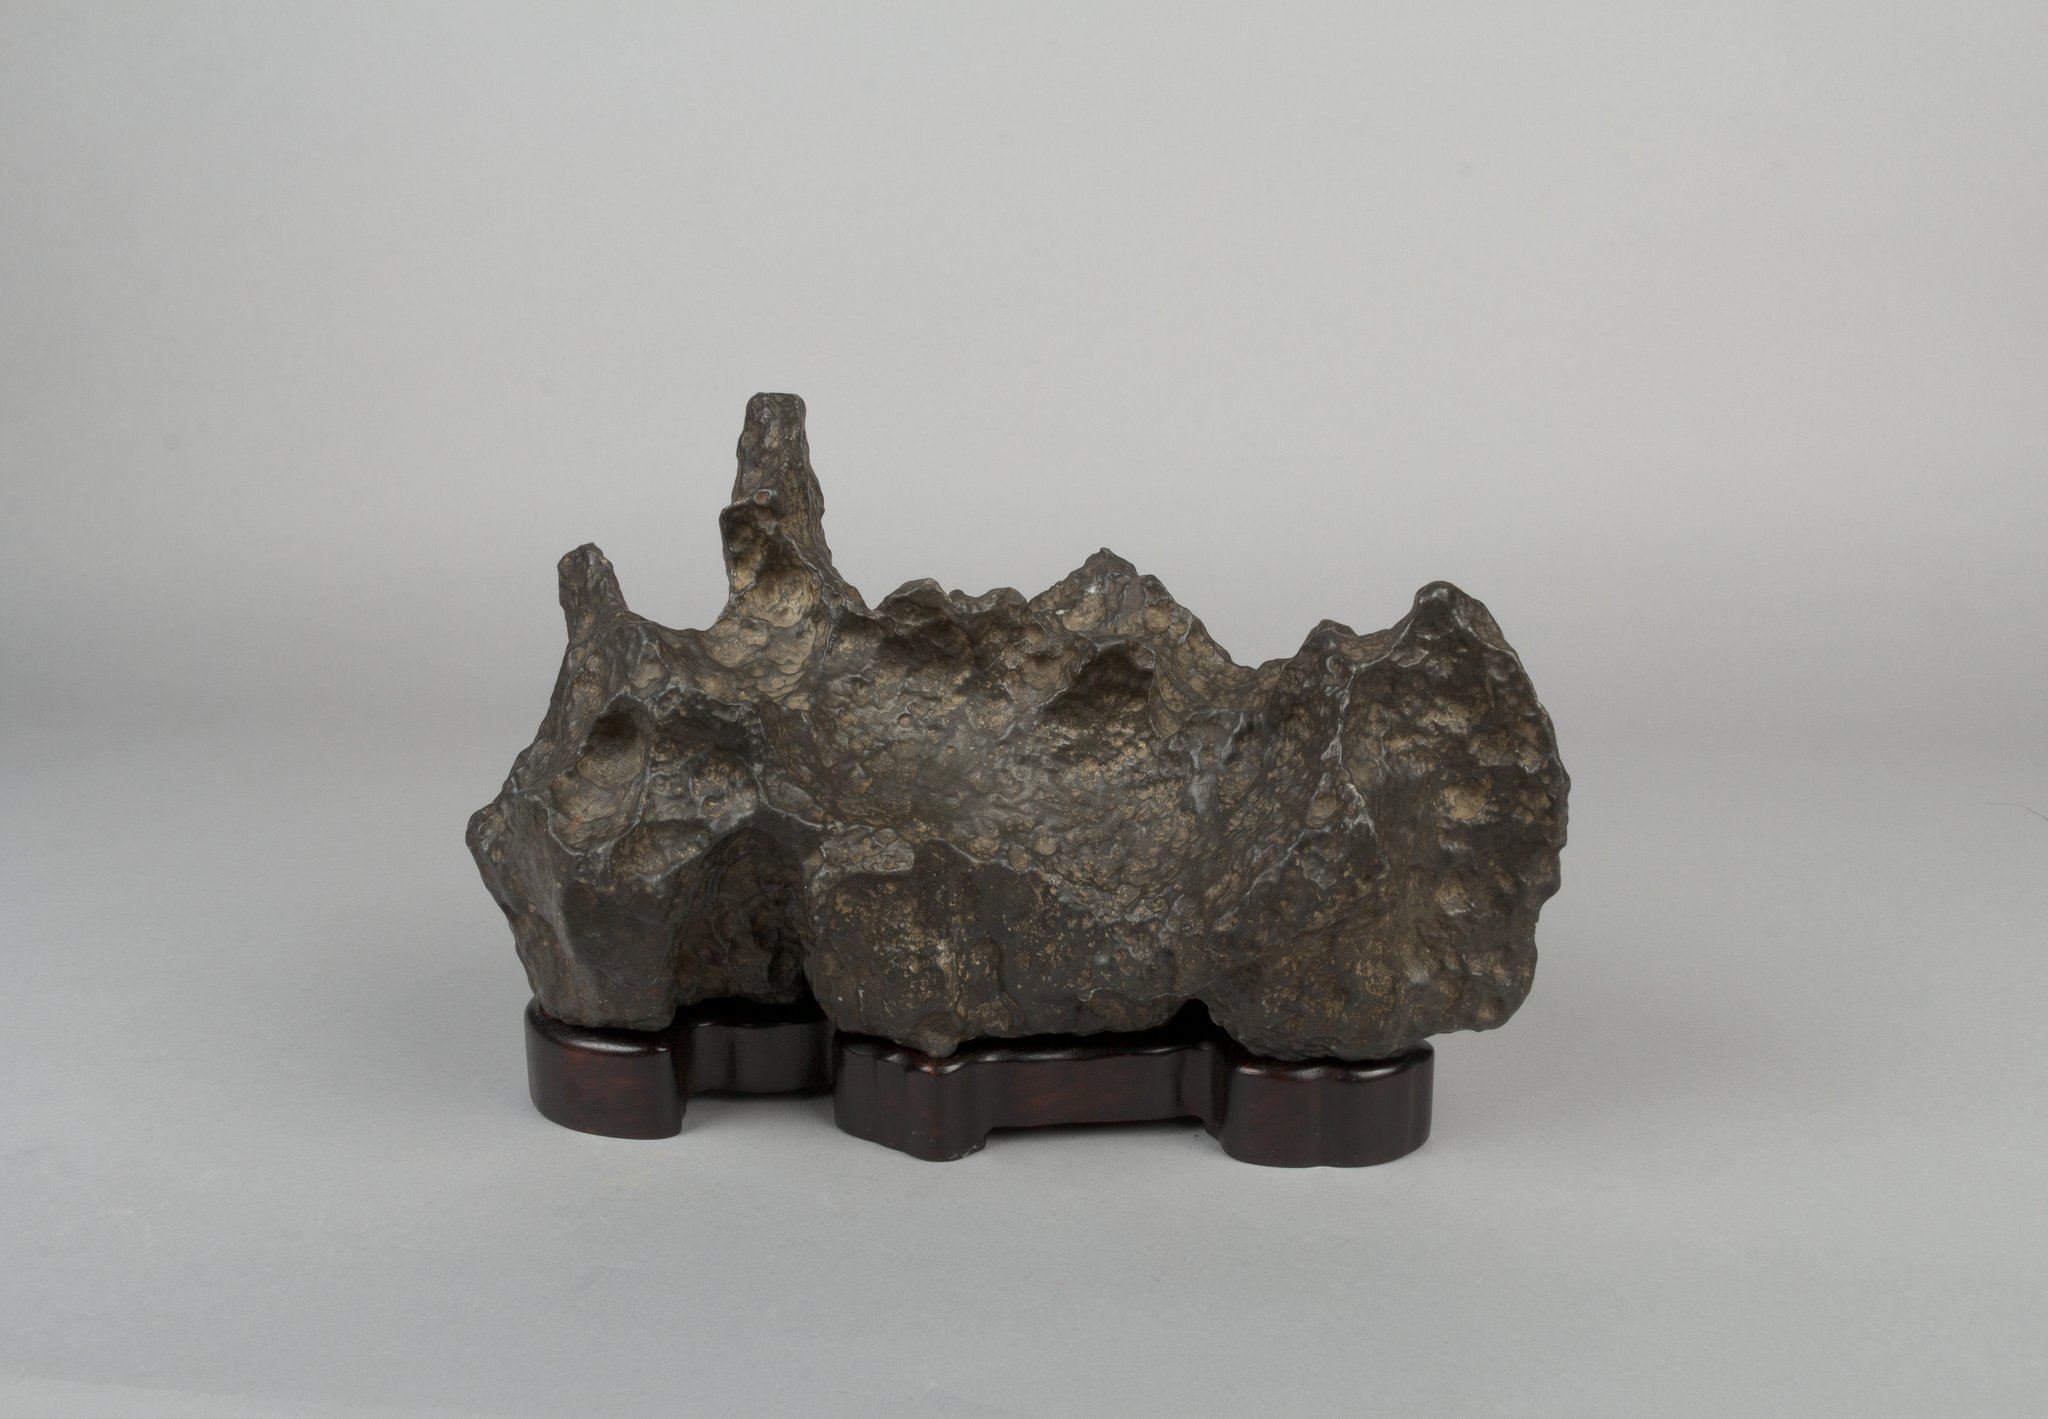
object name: scholar's rock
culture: chinese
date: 1644-1911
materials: limestone, wood